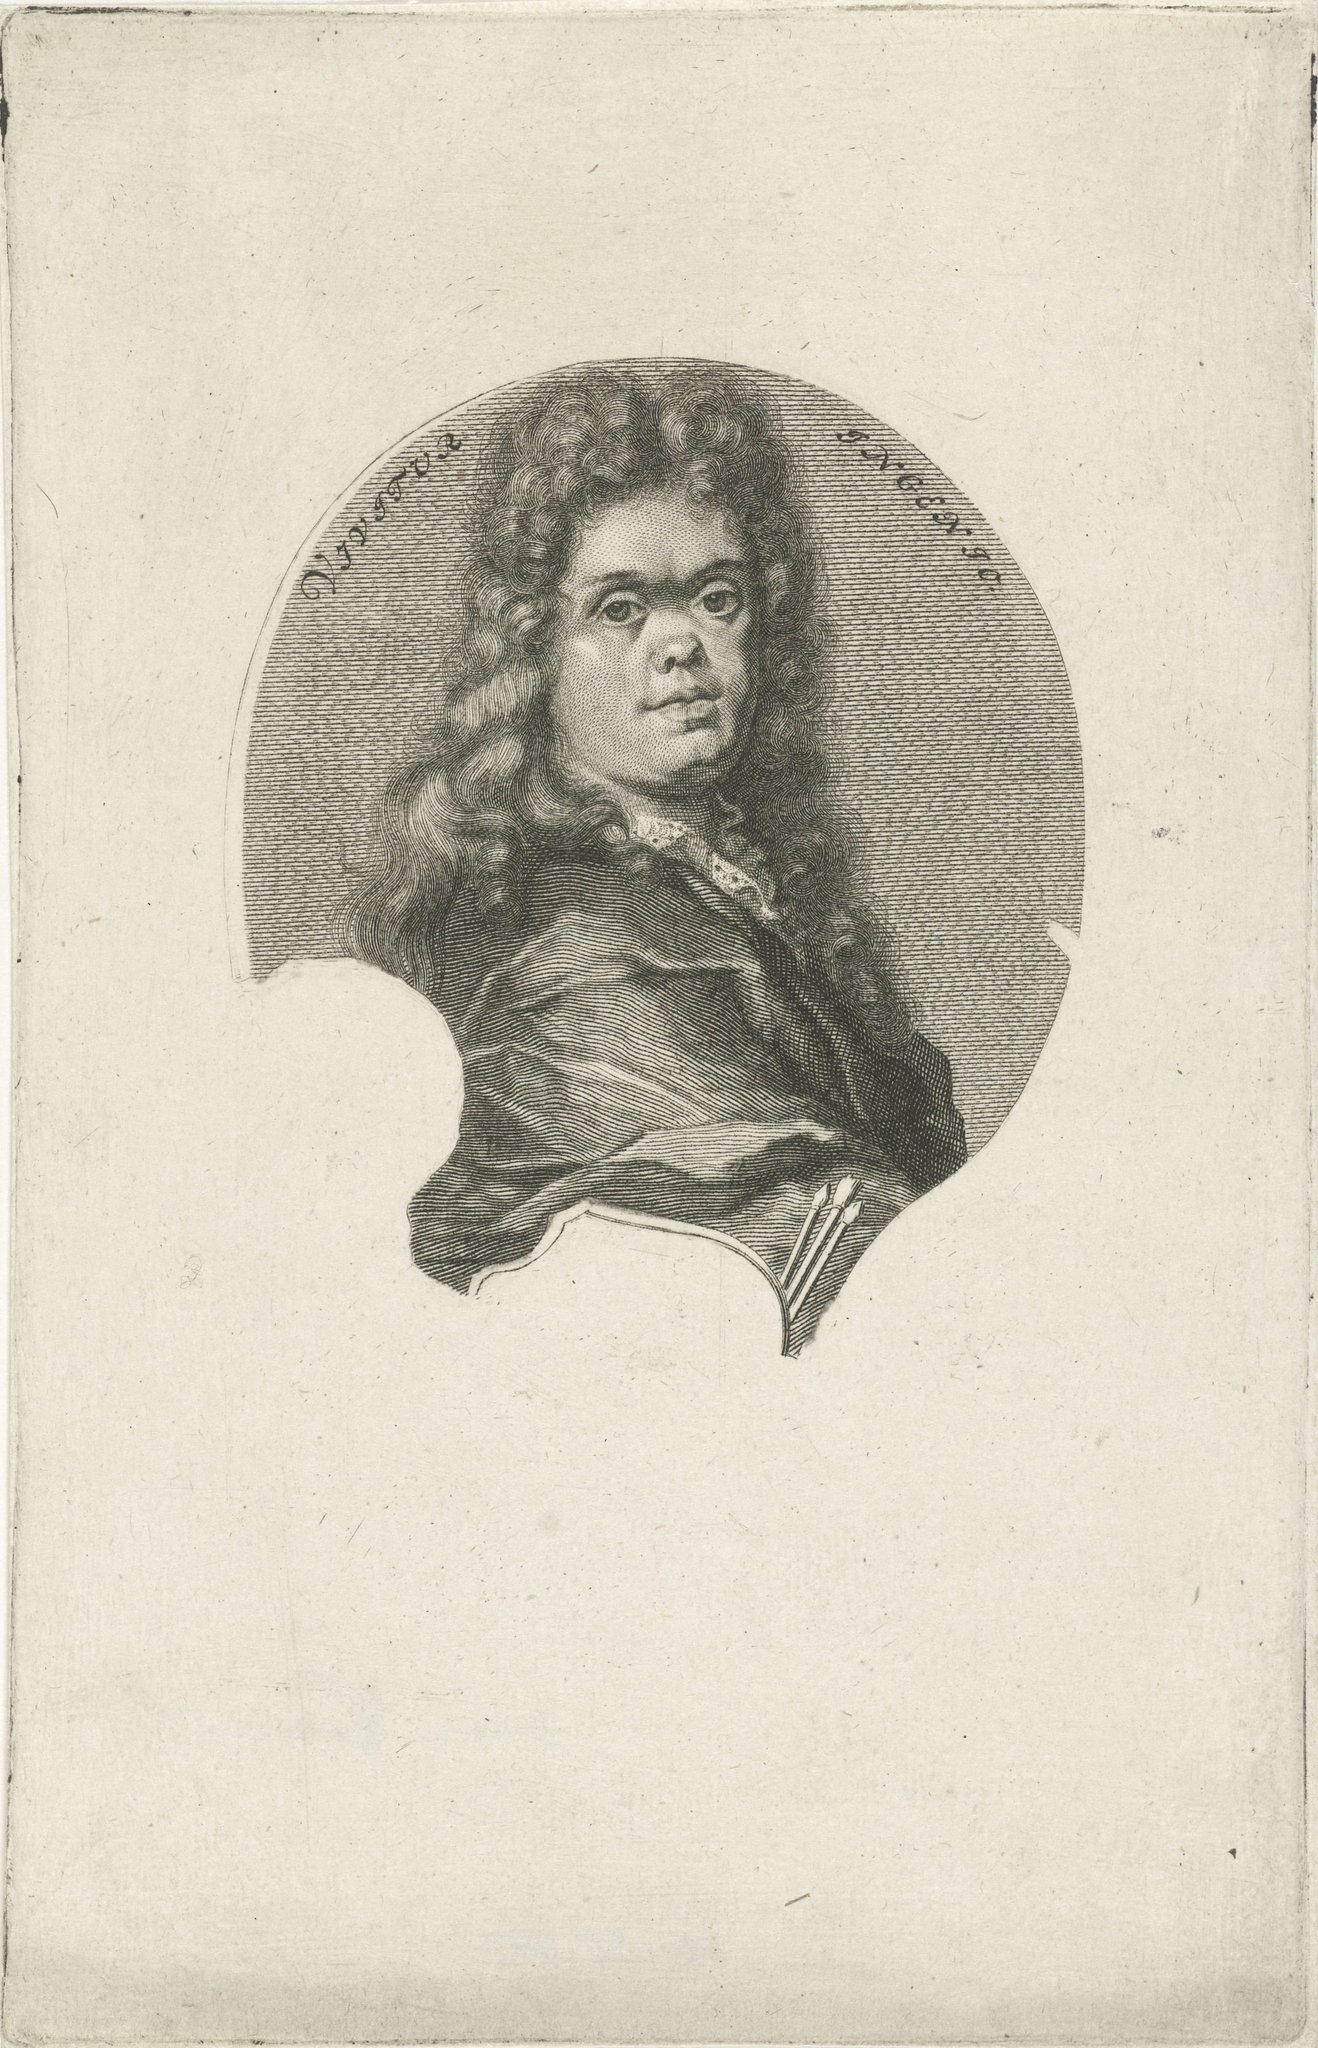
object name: print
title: Portret van Gerard De Lairesse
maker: pieter van gunst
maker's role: print maker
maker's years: 1658-1731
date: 1659-1731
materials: paper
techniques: engraving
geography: amsterdam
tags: draughtsman, gerard de lairesse, portrait, self-portrait of painter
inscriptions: collector's mark: Lugt 2228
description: Gerard De Lairesse, een Luikse prentmaker en schilder. Boven zijn hoofd het motto: "Vivitura Ingenio". Het portret heeft de vorm van een schilderspalet.